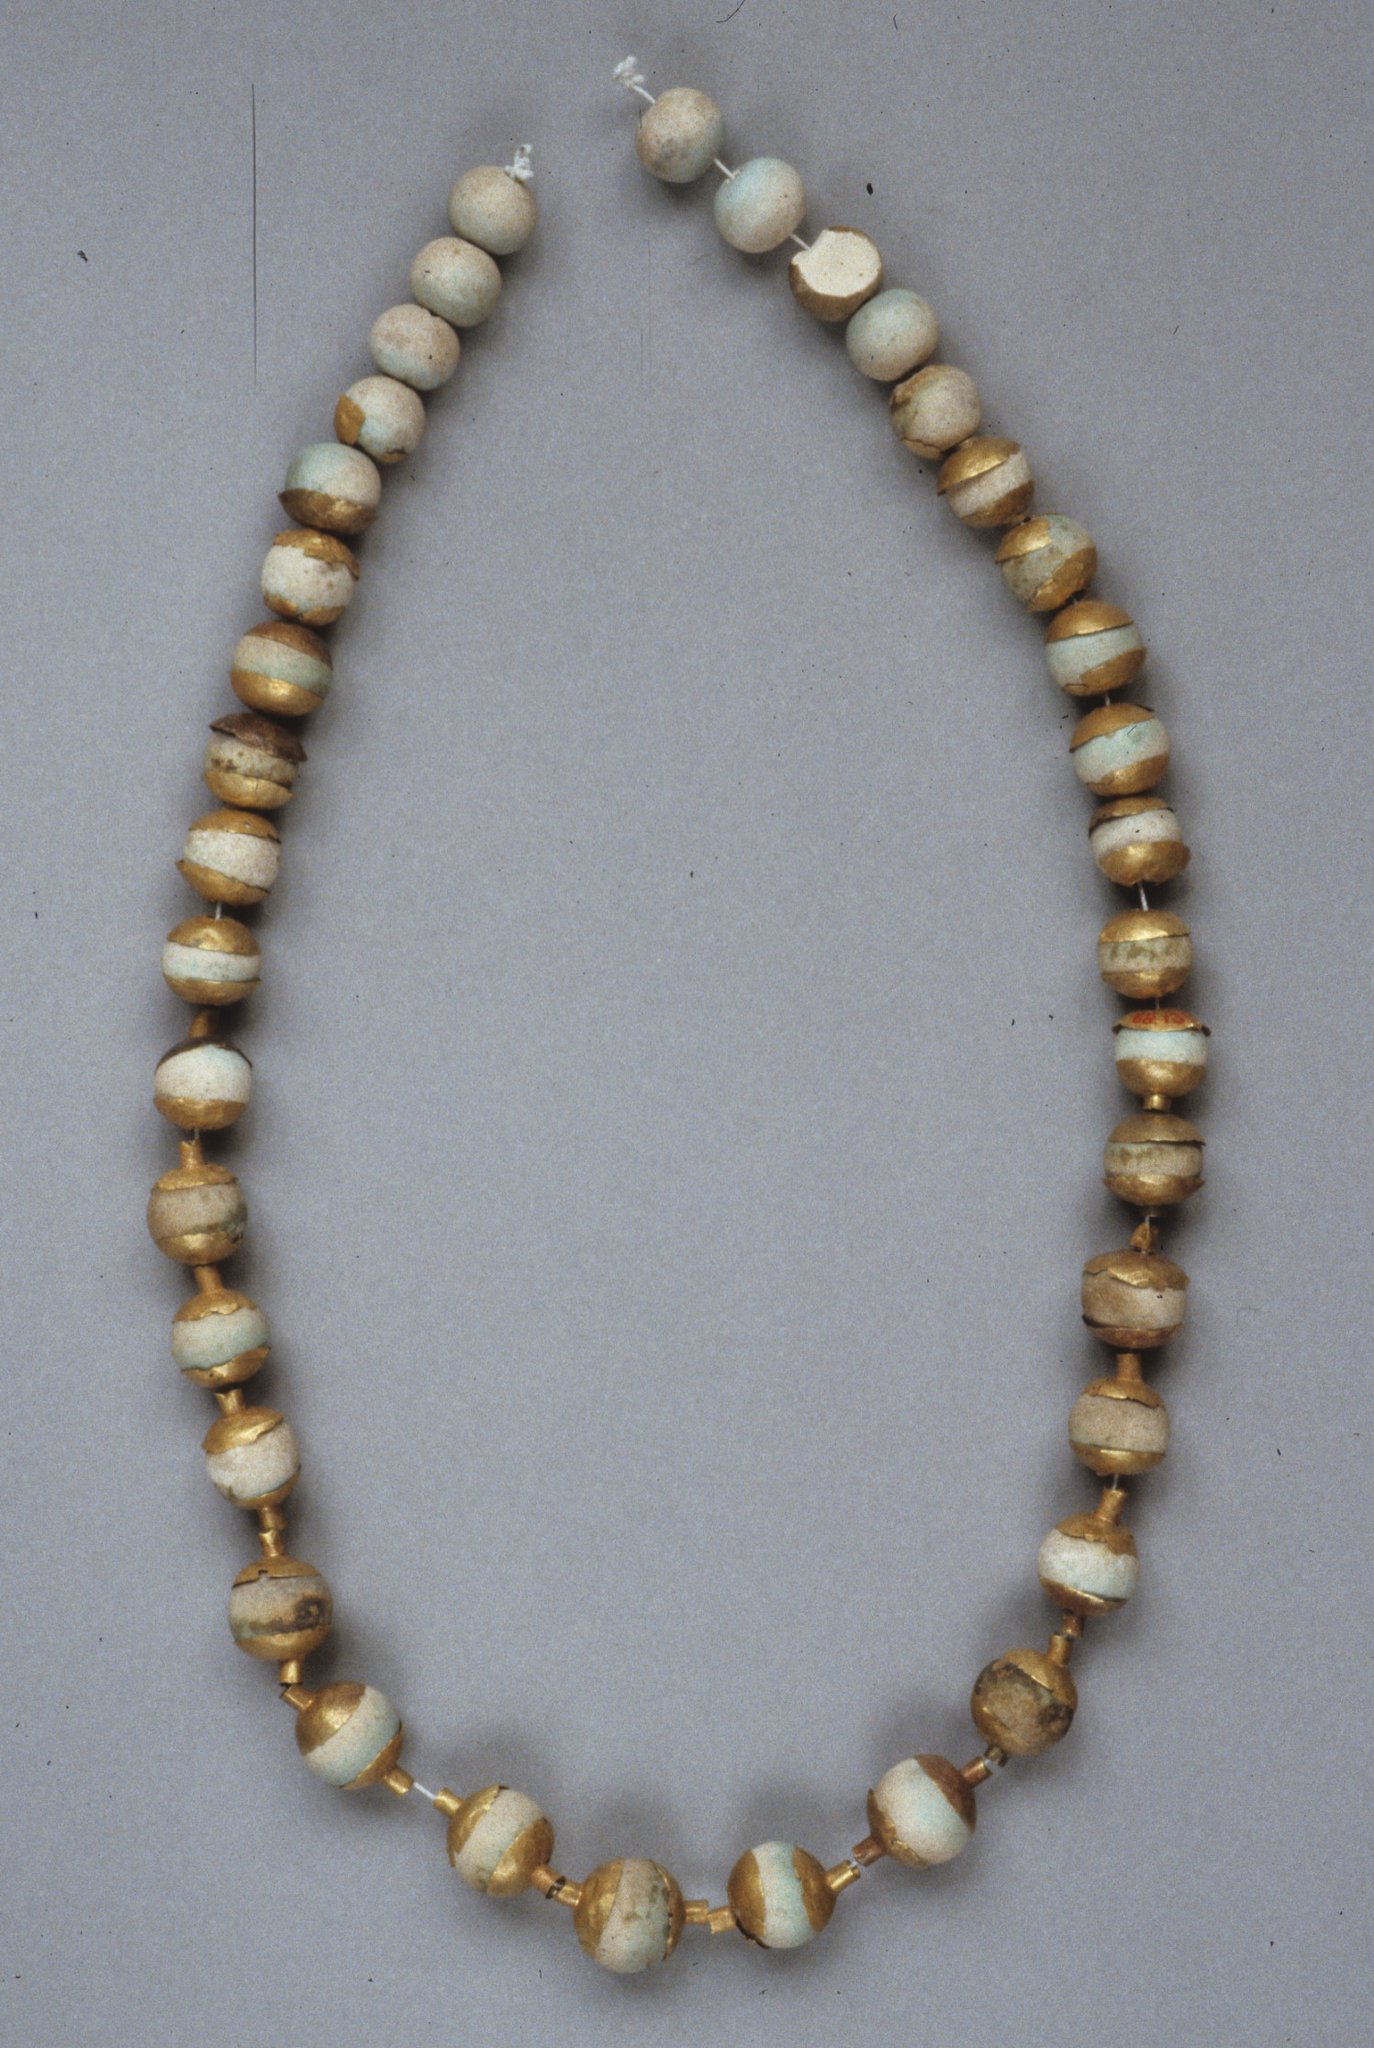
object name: bead, ball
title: Globular Beads with Caps, Strung as a Necklace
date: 1648-1540 BCE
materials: faience, gold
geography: eastern delta